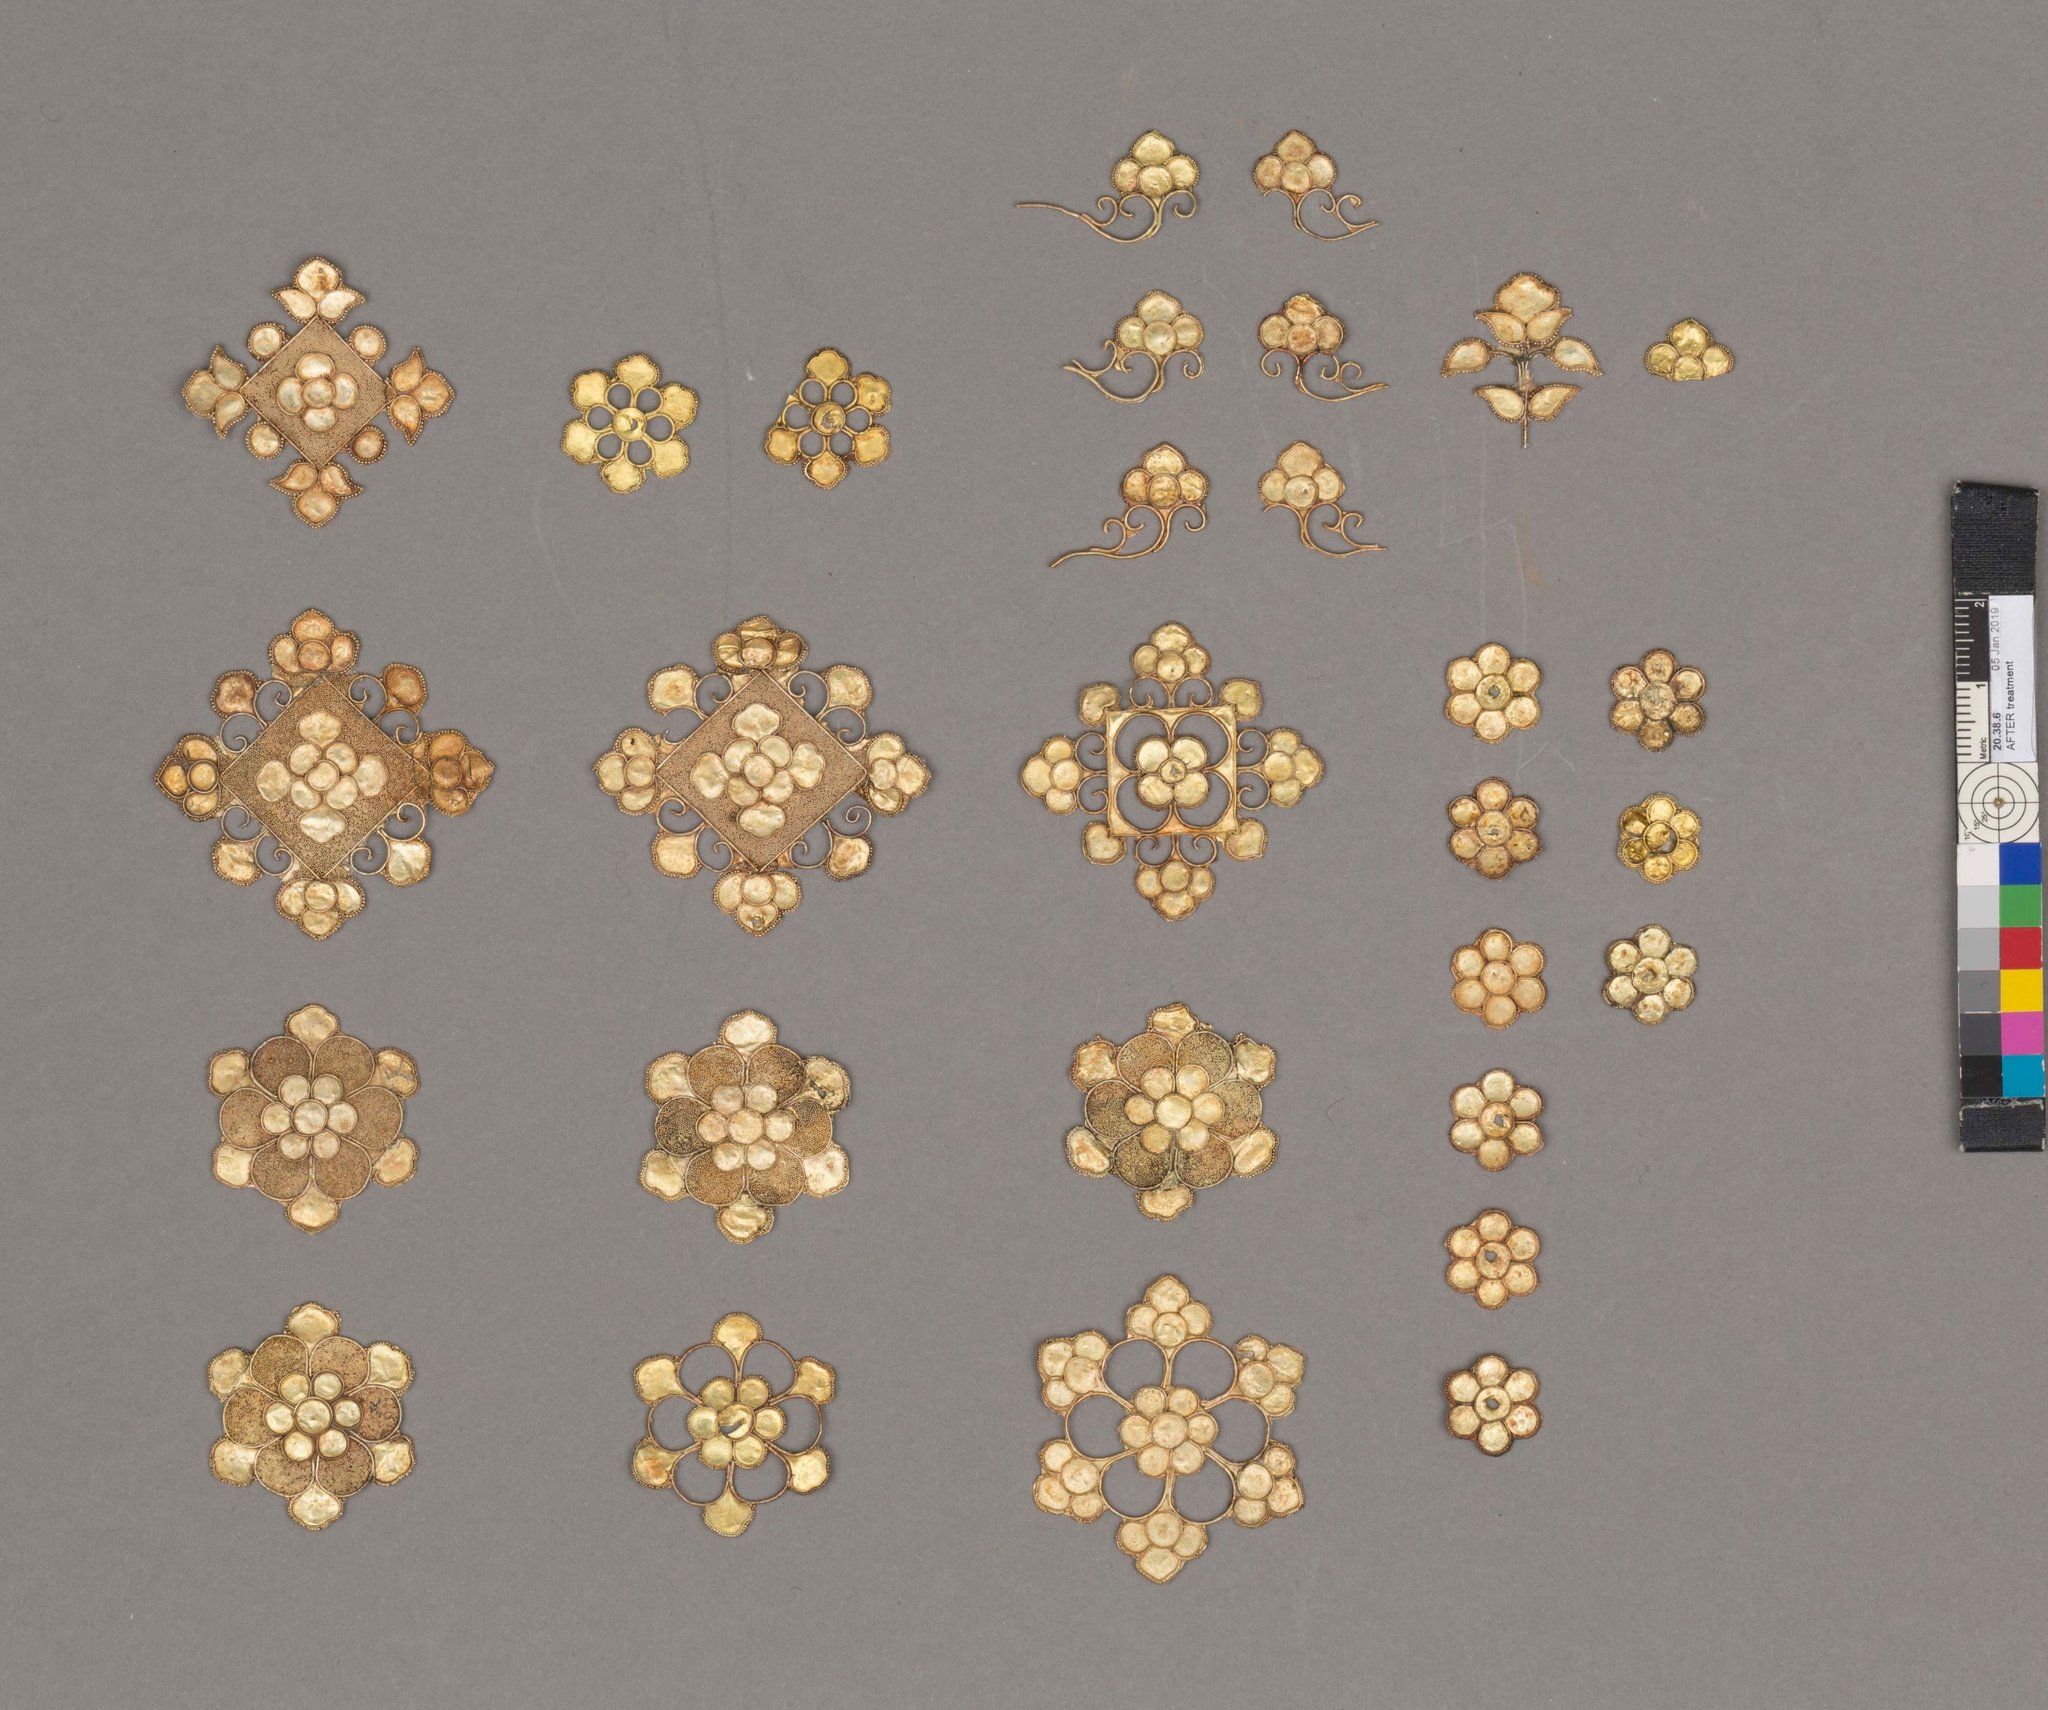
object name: rosette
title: Rosettes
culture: chinese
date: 618-907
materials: gold